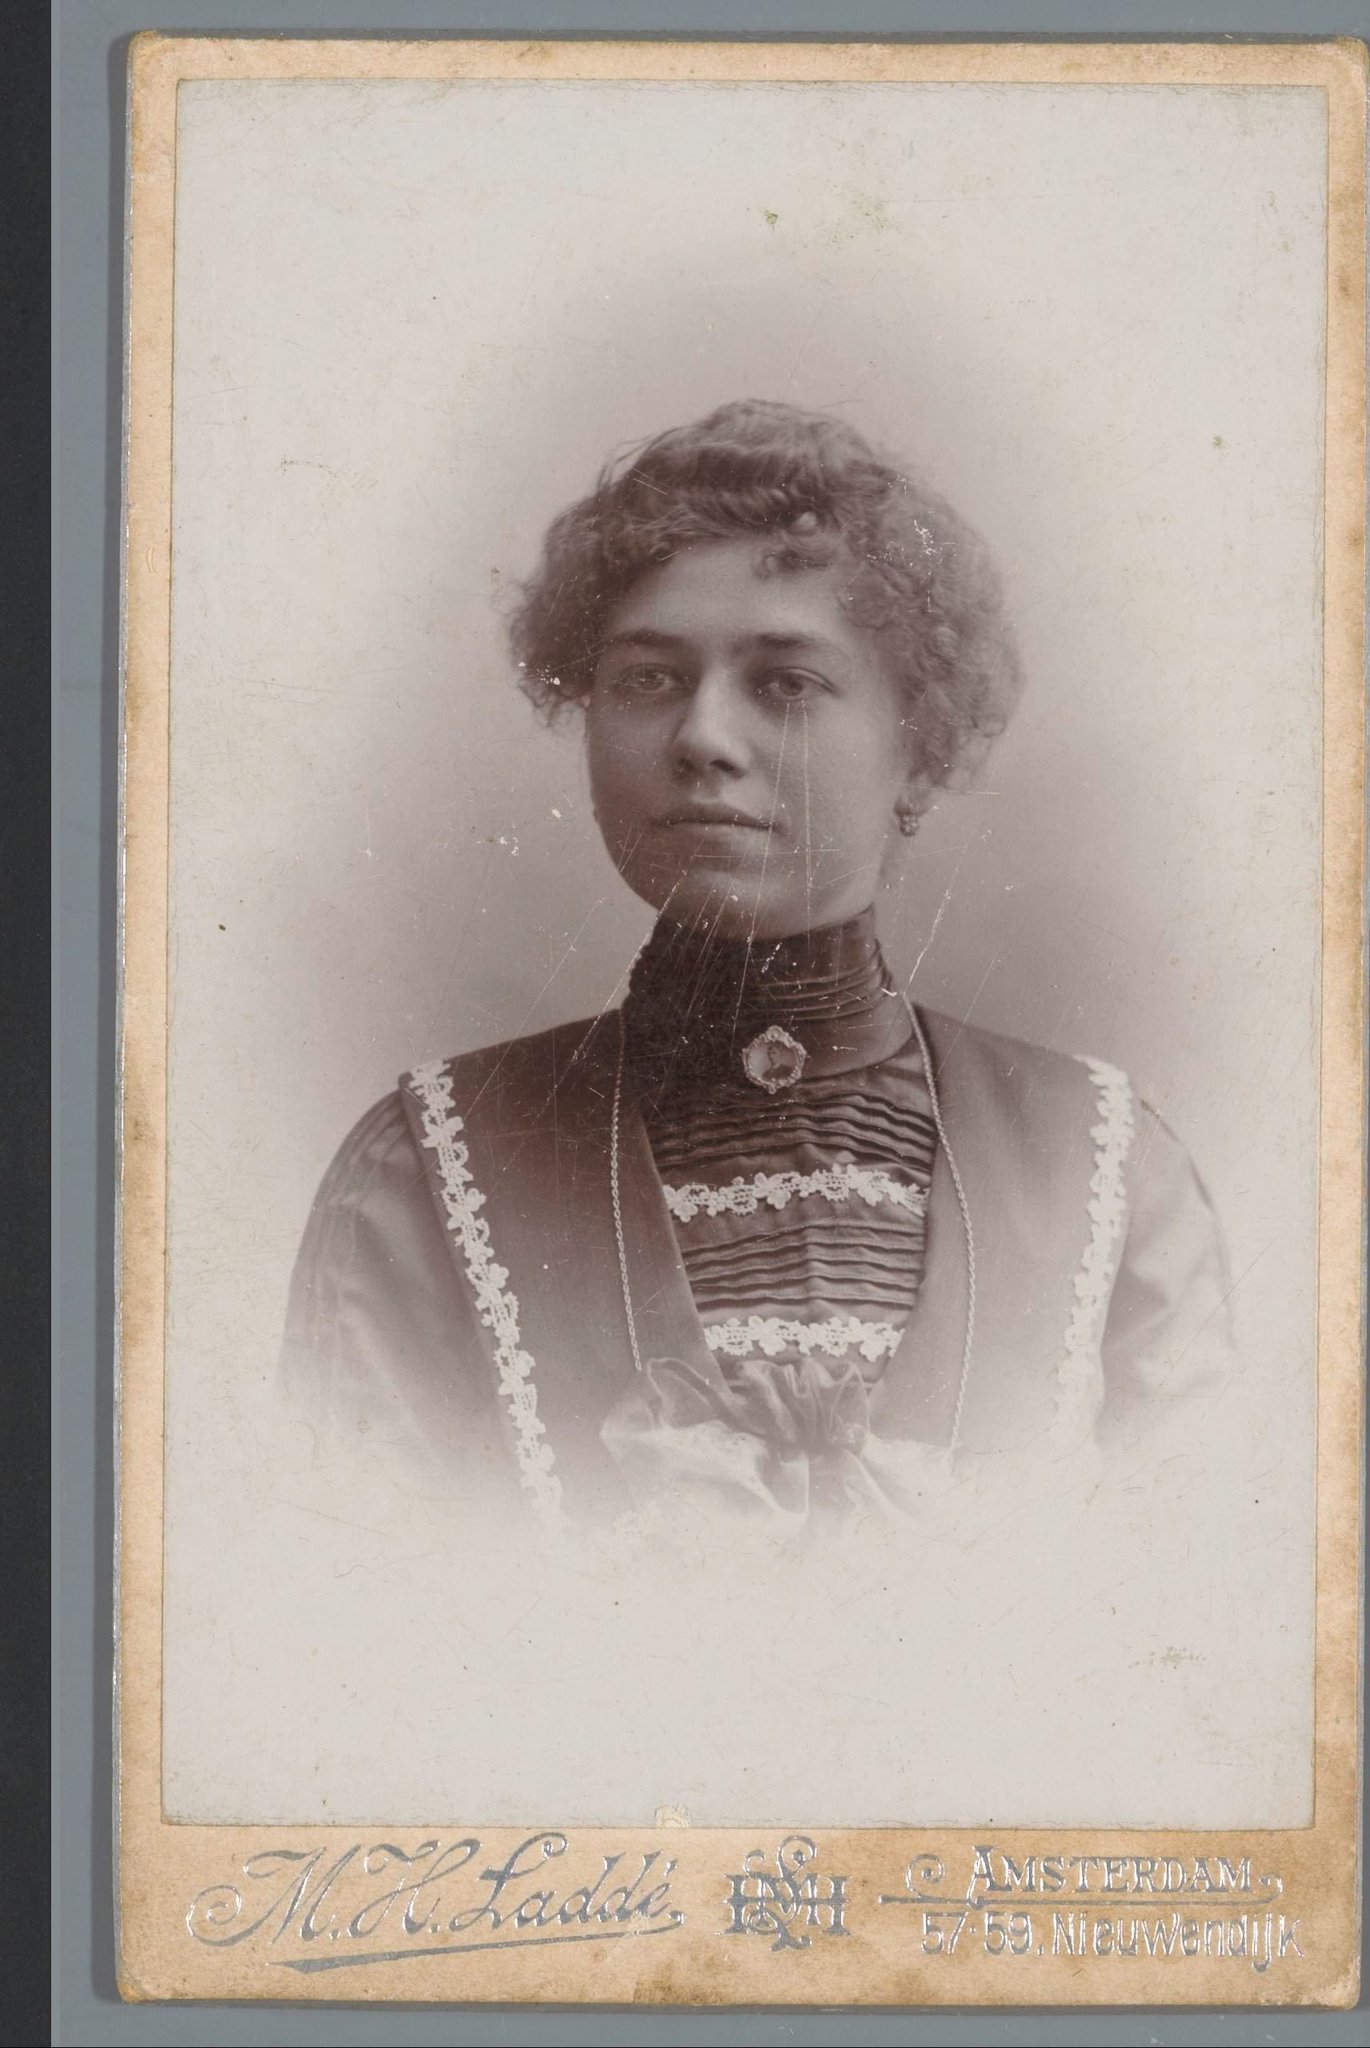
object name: photograph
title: Portret van een onbekende vrouw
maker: machiel hendricus laddé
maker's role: fotograaf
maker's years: 1866-1932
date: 1892-1906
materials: cardboard, photographic support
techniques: collodion silver print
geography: amsterdam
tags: historical persons - bb - woman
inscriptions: inscription: ‘No...../ Photographie/ Artistique/ M. H. LADDÉ/ BOVEN DE FIRMA/ MERKELBACH & Co./ AMSTERDAM/ 57-59/ NIEUWENDIJK/ Het Cliché wordt voor verdere bestellingen bewaard.’